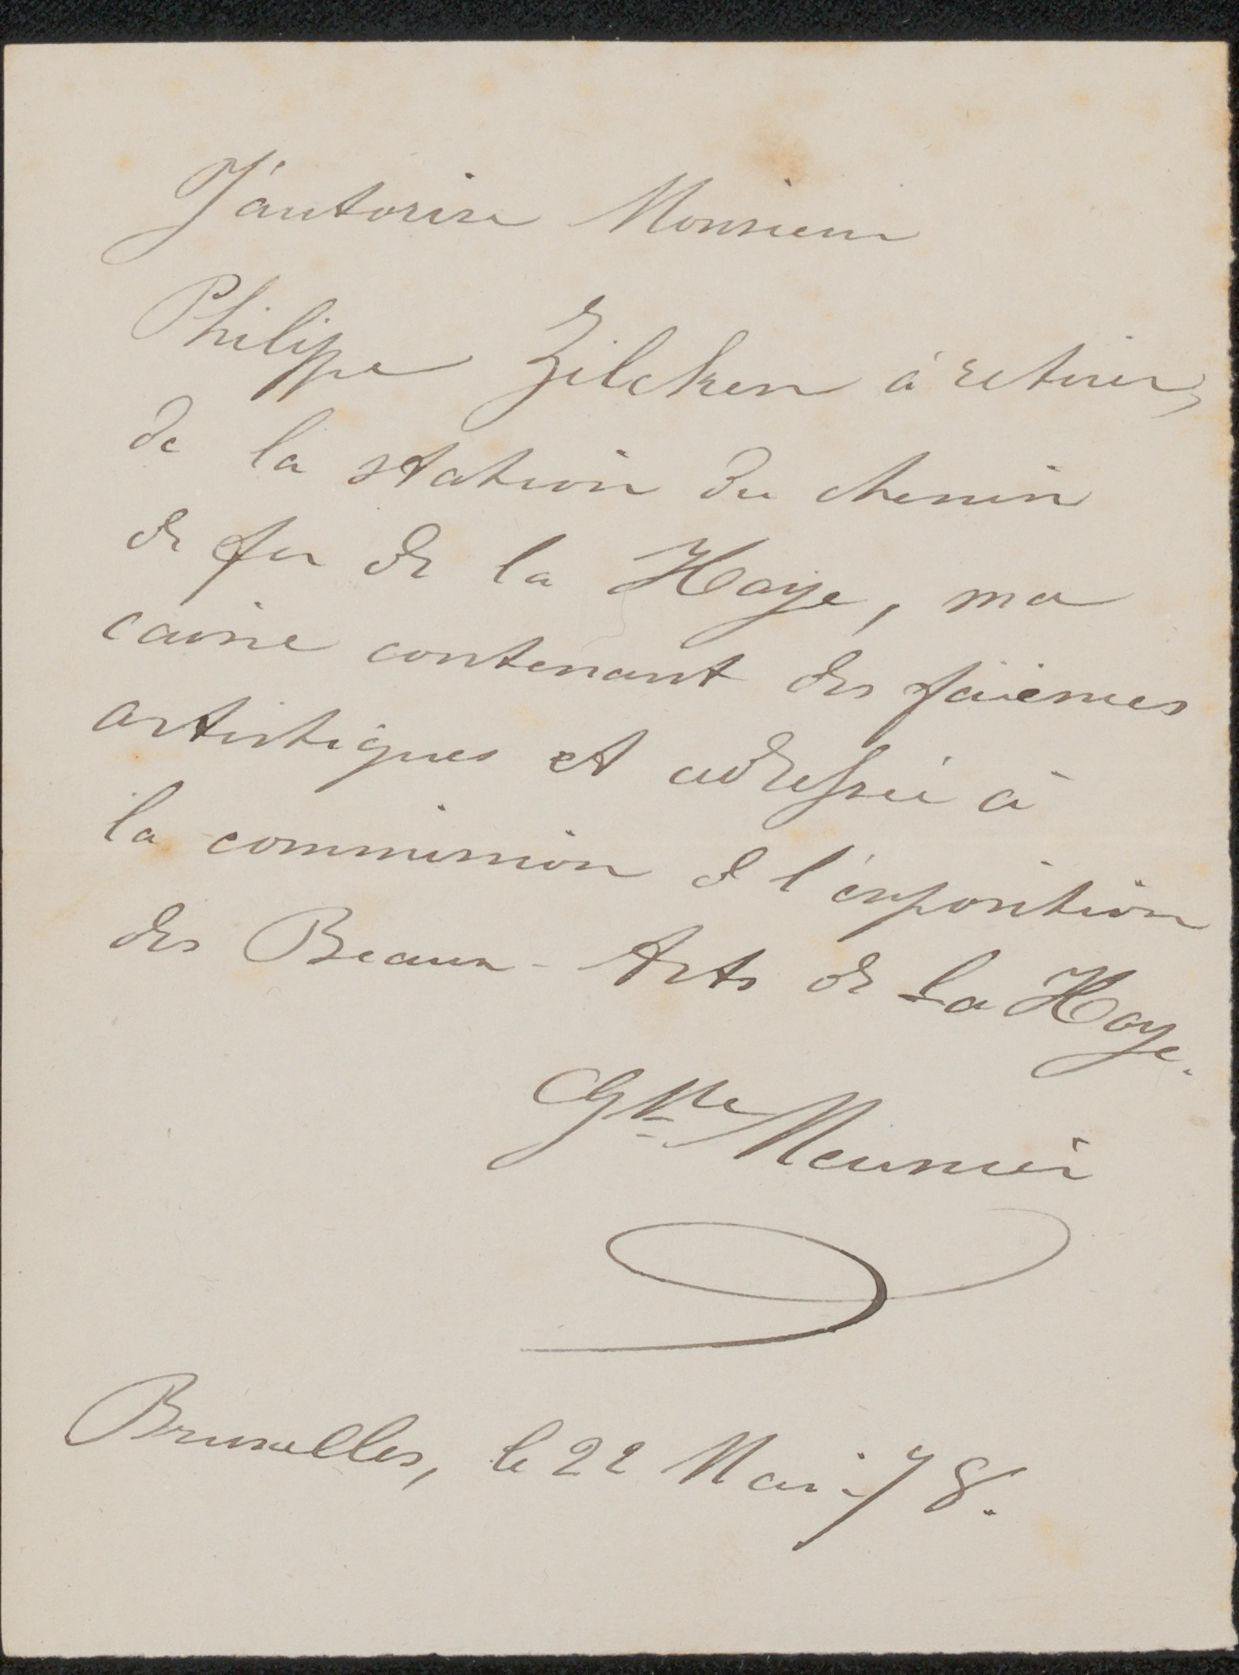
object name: letter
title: Brief aan anoniem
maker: georgette meunier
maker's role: painter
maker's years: 1859-1951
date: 1878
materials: ink, paper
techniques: pen, writing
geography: brussels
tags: painter, draughtsman, philip zilcken, applied arts, arts and crafts; industrial design, exhibition ~ art, the hague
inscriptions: collector's mark: ‘RPK’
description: Brief vormt een bijlage bij RP-D-1982-43-MEUNIER(G.)-3A.